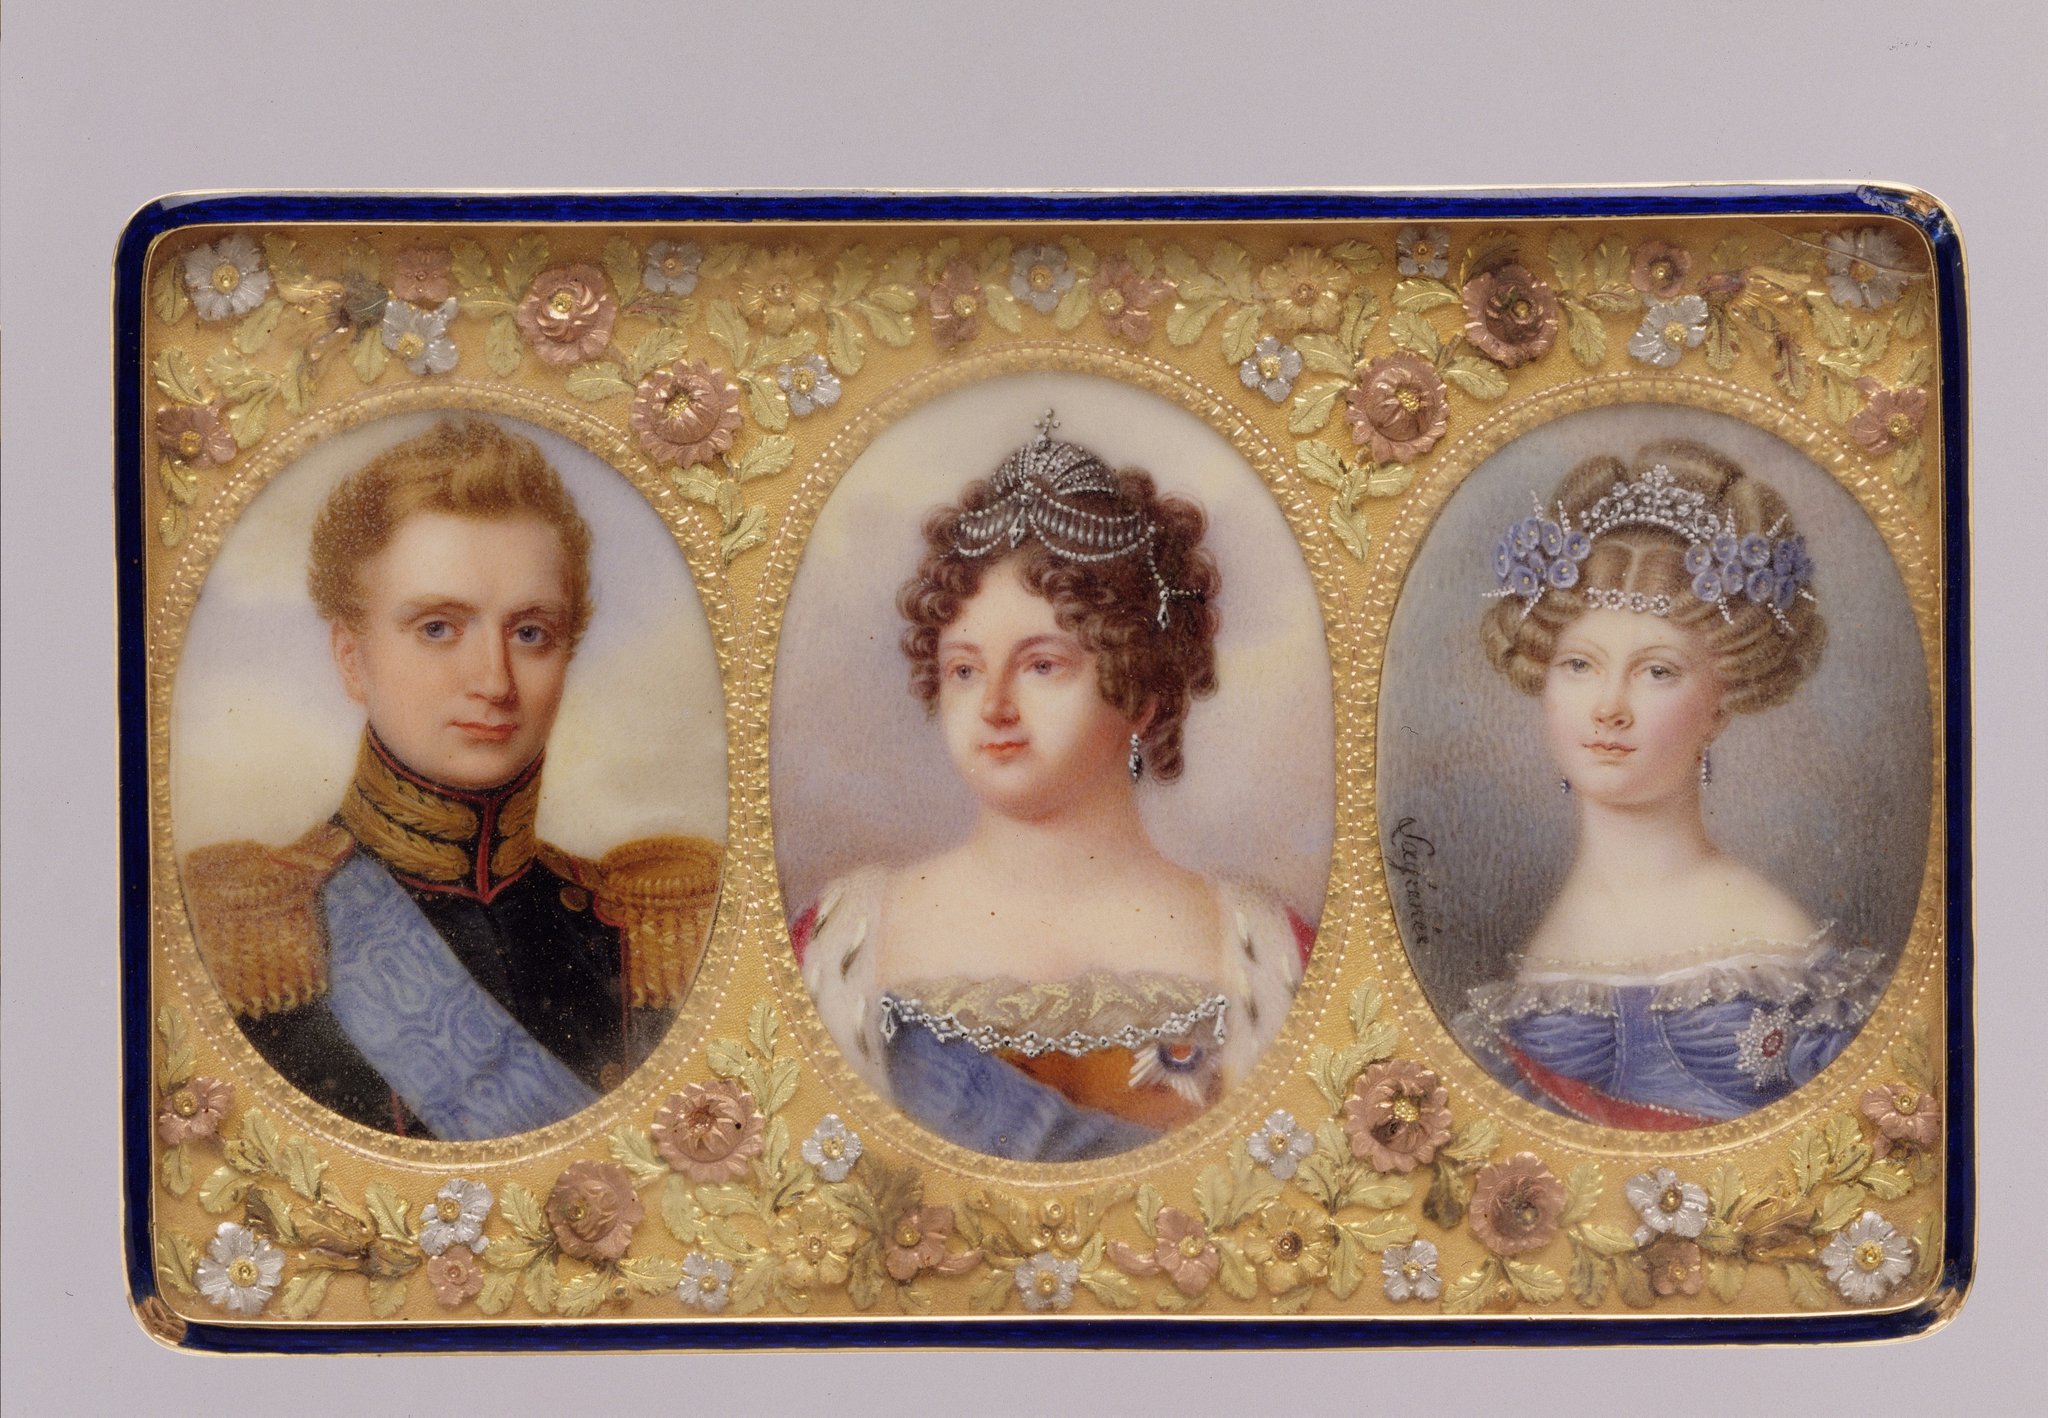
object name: snuffbox, painting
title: Snuffbox with portraits of Empress Maria Feodorovna, her Son Grand Duke Michael Pavlovich, and her daughter-in-law Elena Pavlovna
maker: anthelme françois lagrenée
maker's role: artist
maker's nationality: french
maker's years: 1774-1832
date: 1823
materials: enamel, glass, gold, ivory, silver, shell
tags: men,portraits,women,flowers